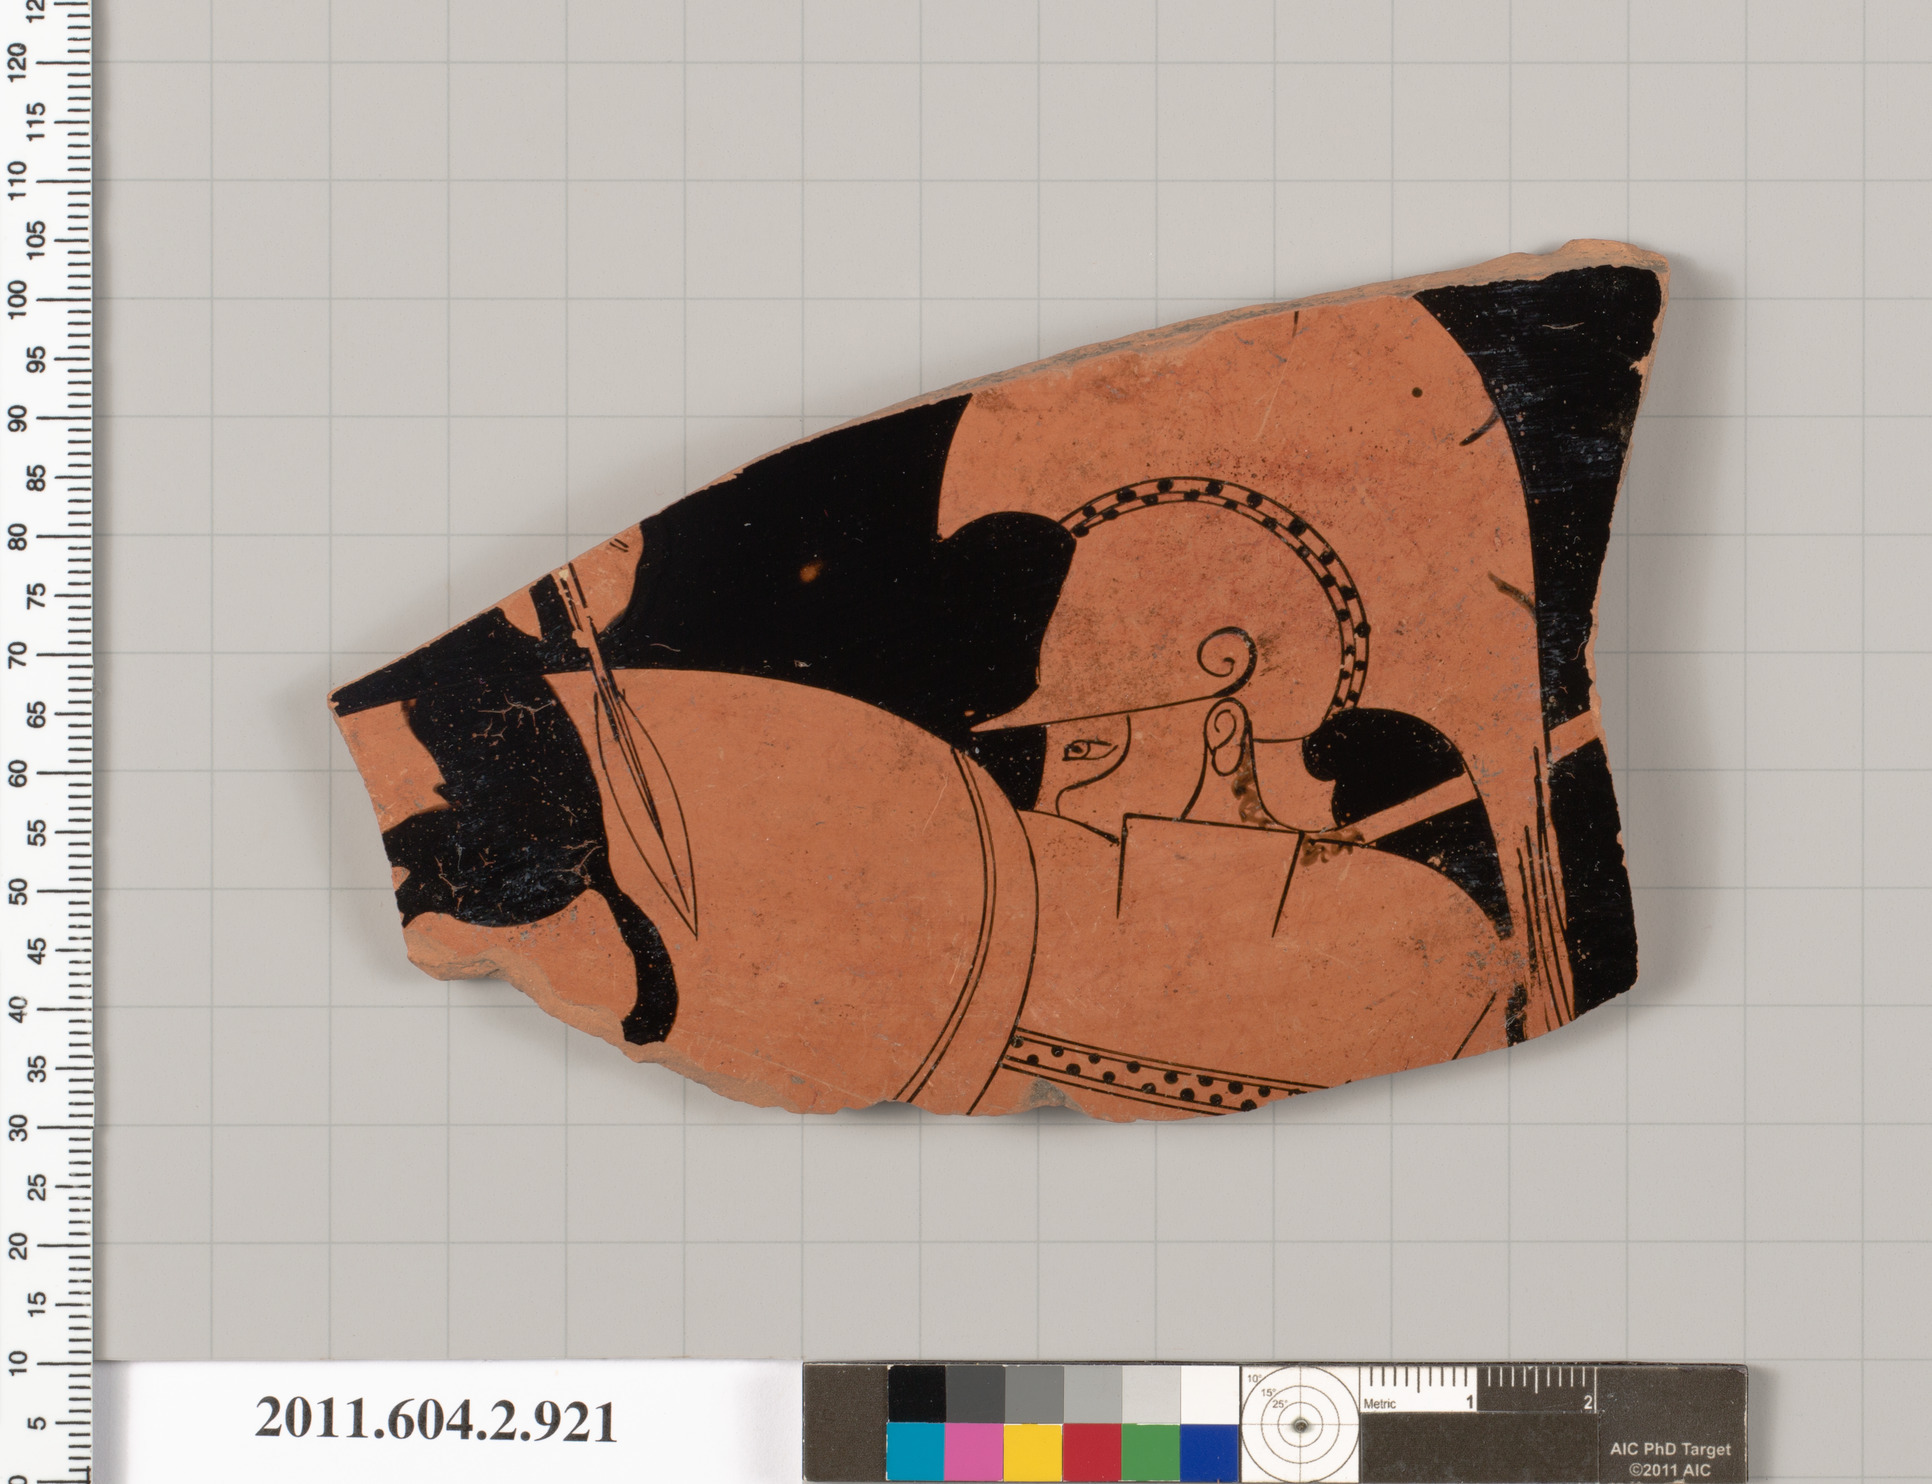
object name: kalpis fragment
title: Terracotta fragment of a hydria: kalpis (water jar)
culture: greek, attic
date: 480-470 BCE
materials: terracotta